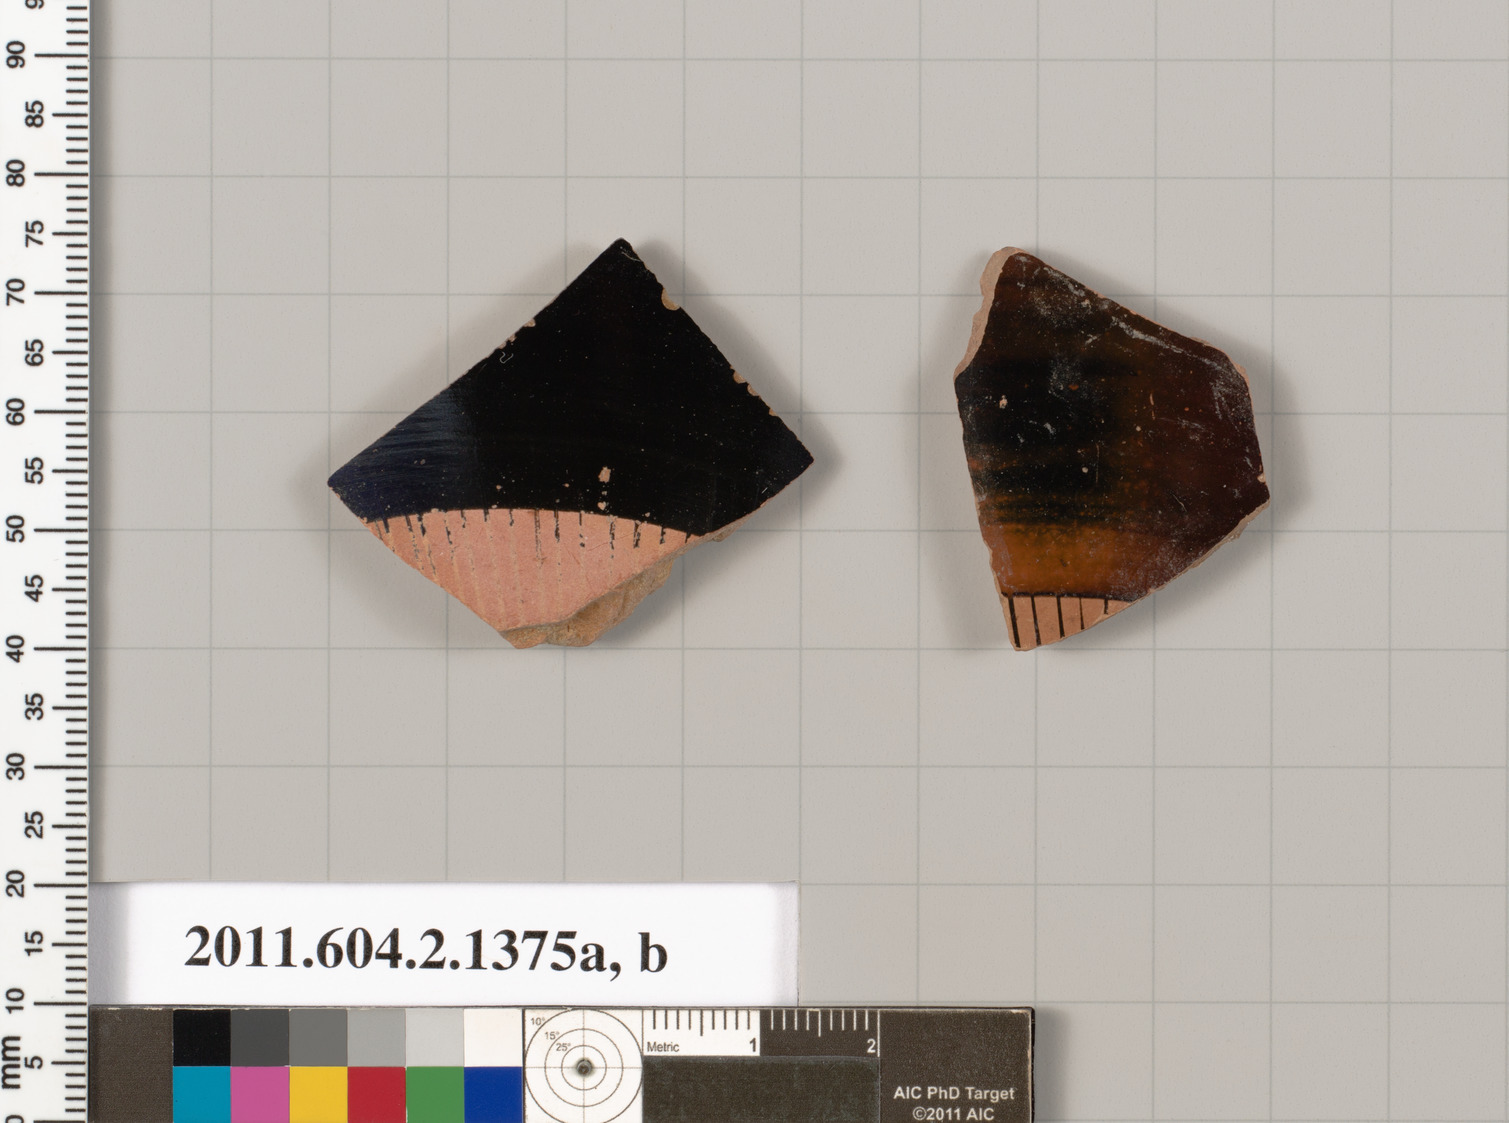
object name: skyphos fragment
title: Terracotta fragments of skyphoi (deep drinking cups)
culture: greek, attic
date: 475-451 BCE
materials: terracotta